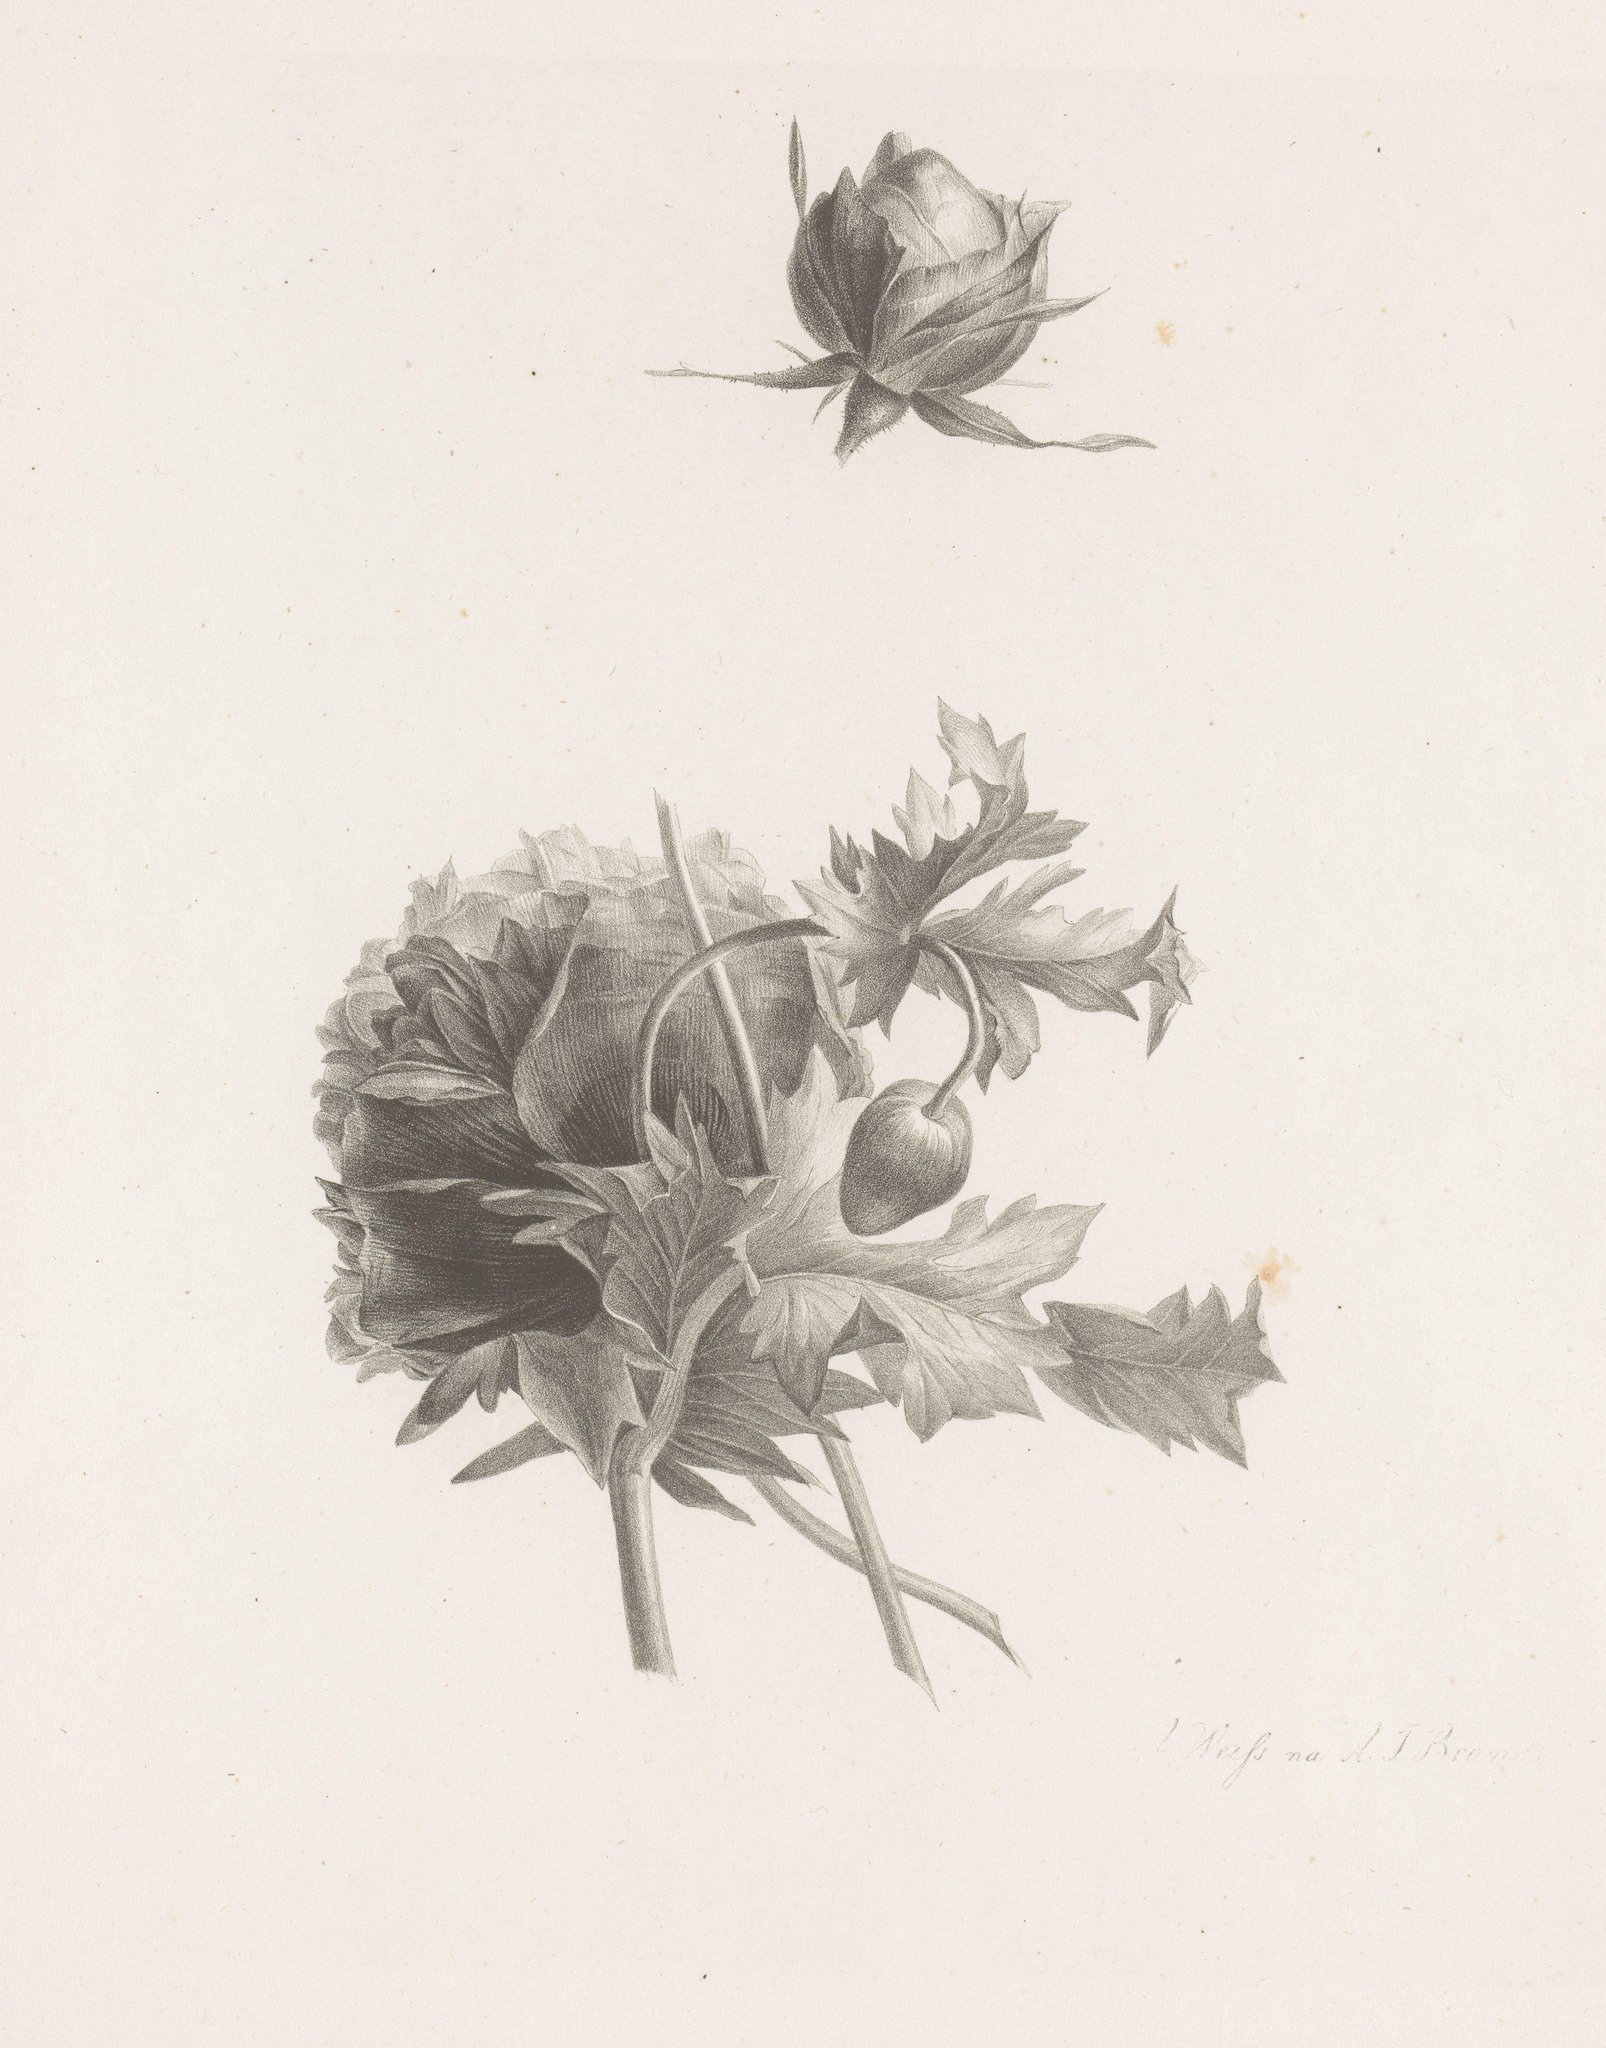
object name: print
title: Roos en andere bloem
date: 1820-1833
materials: paper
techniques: lithograph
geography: amsterdam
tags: flowers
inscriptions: collector's mark: Lugt 2228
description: Onderdeel van een omslag met in totaal zevenenzeventig lithografieën van bloemen en fruit.